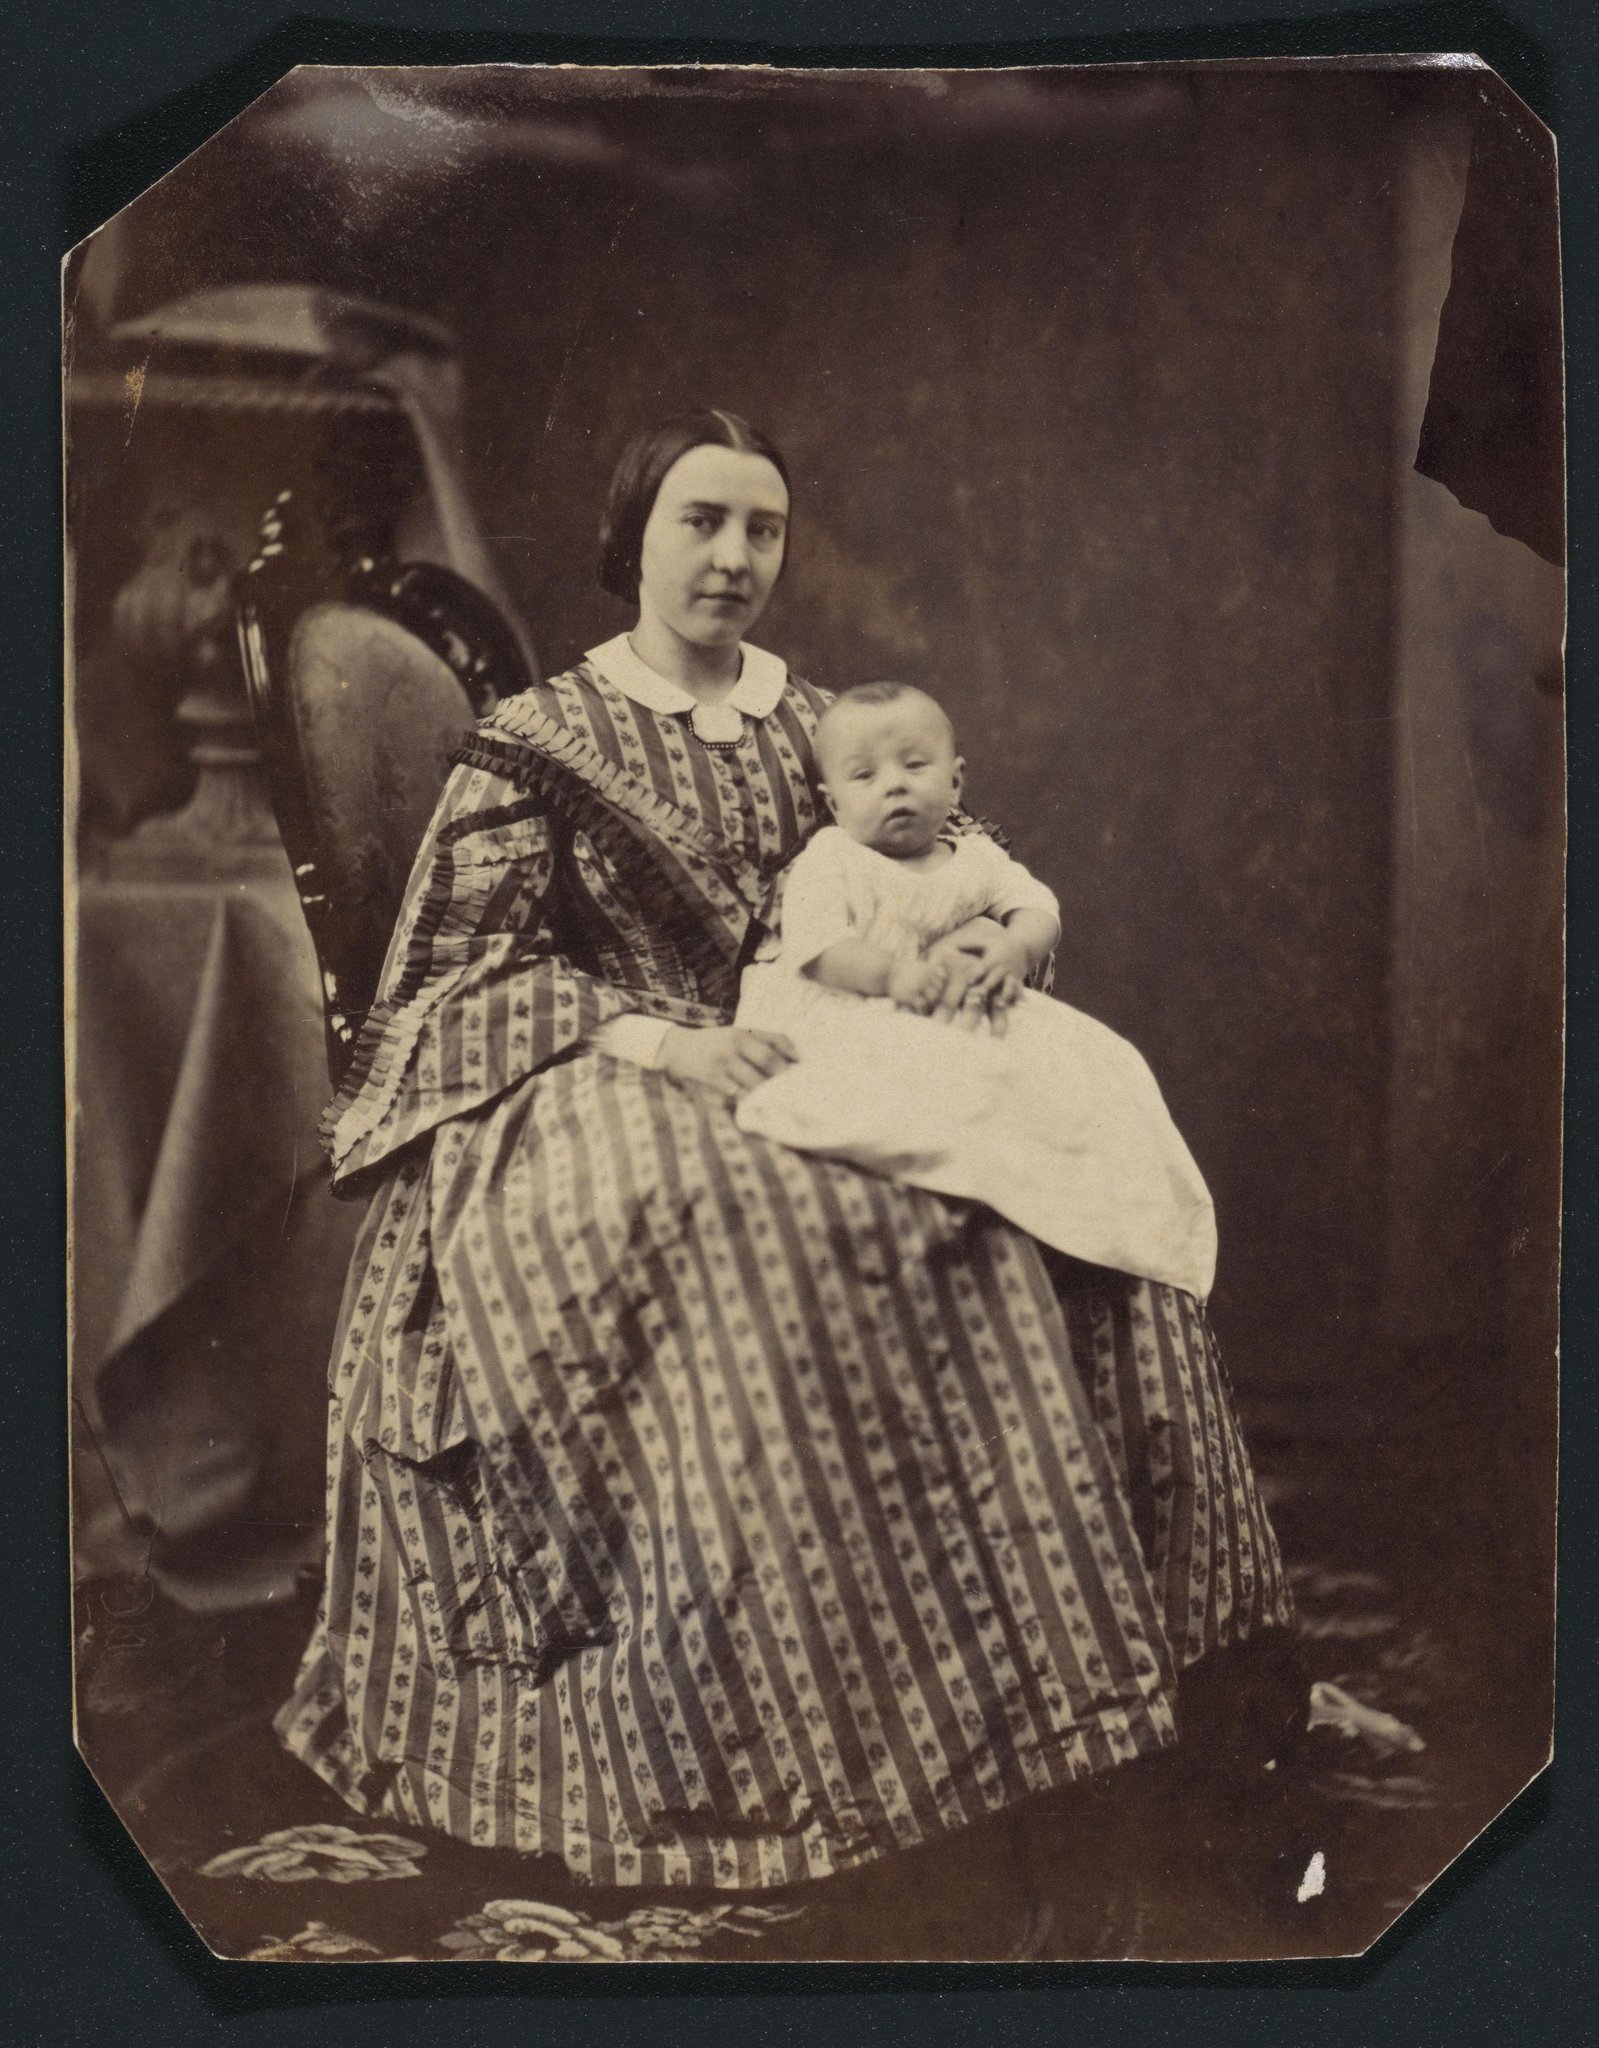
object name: photograph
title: Portret van mevrouw Six-d'Ablaing in een gestreepte jurk met haar baby Henk Six op schoot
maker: Anonymous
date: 1861-1862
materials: cardboard, photographic support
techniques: albumen print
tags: leiden, mother and baby or young child, dress, gown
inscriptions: inscription: ‘Mevrouw Six-d'Ablaing 1837-1872 met Henk Six geb. 13 jan. 1861-1877. Henk’